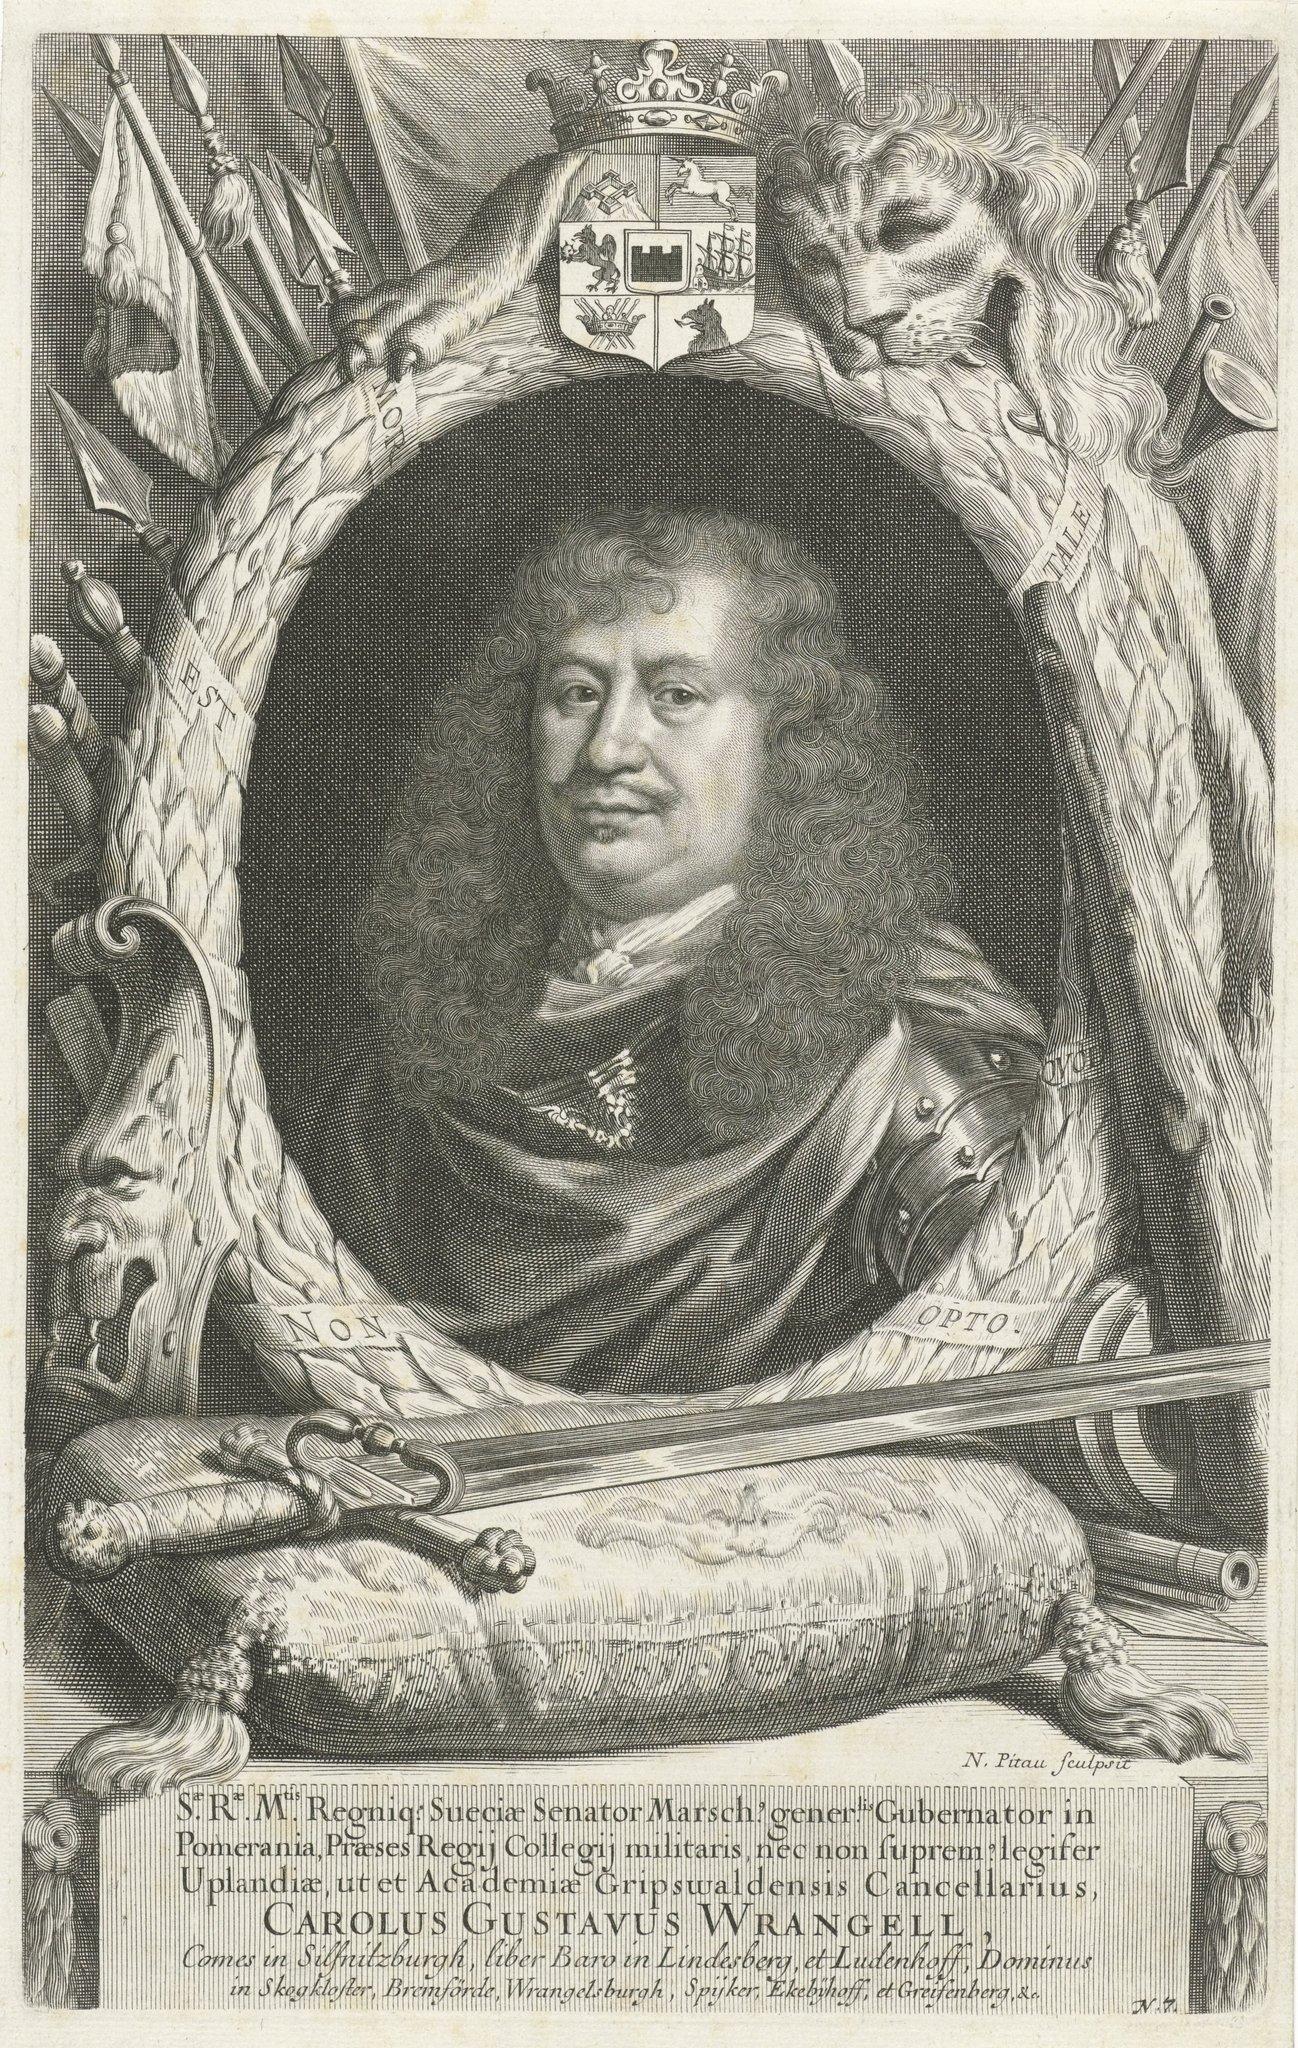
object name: print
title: Portret van Carl Gustaf Wrangel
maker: nicolas pitau (i)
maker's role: print maker, publisher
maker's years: 1632-1671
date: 1644-1671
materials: paper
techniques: engraving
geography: paris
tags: attributes of hercules (with name), armour, hacking and thrusting weapons: sword, armorial bearing, heraldry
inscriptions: collector's mark: Lugt 2228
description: Portret van de Zweedse veldheer Carl Gustaf Wrangel. Op de voorgrond zijn zwaard op een kussen. Rondom de omlijsting van zijn portret diverse wapens, een leeuwenvel. De omlijsting is bekroond met zijn wapenschild. Op de plint een zesregelig onderschrift in het Latijn. Rechtsonder gemerkt: N.7.